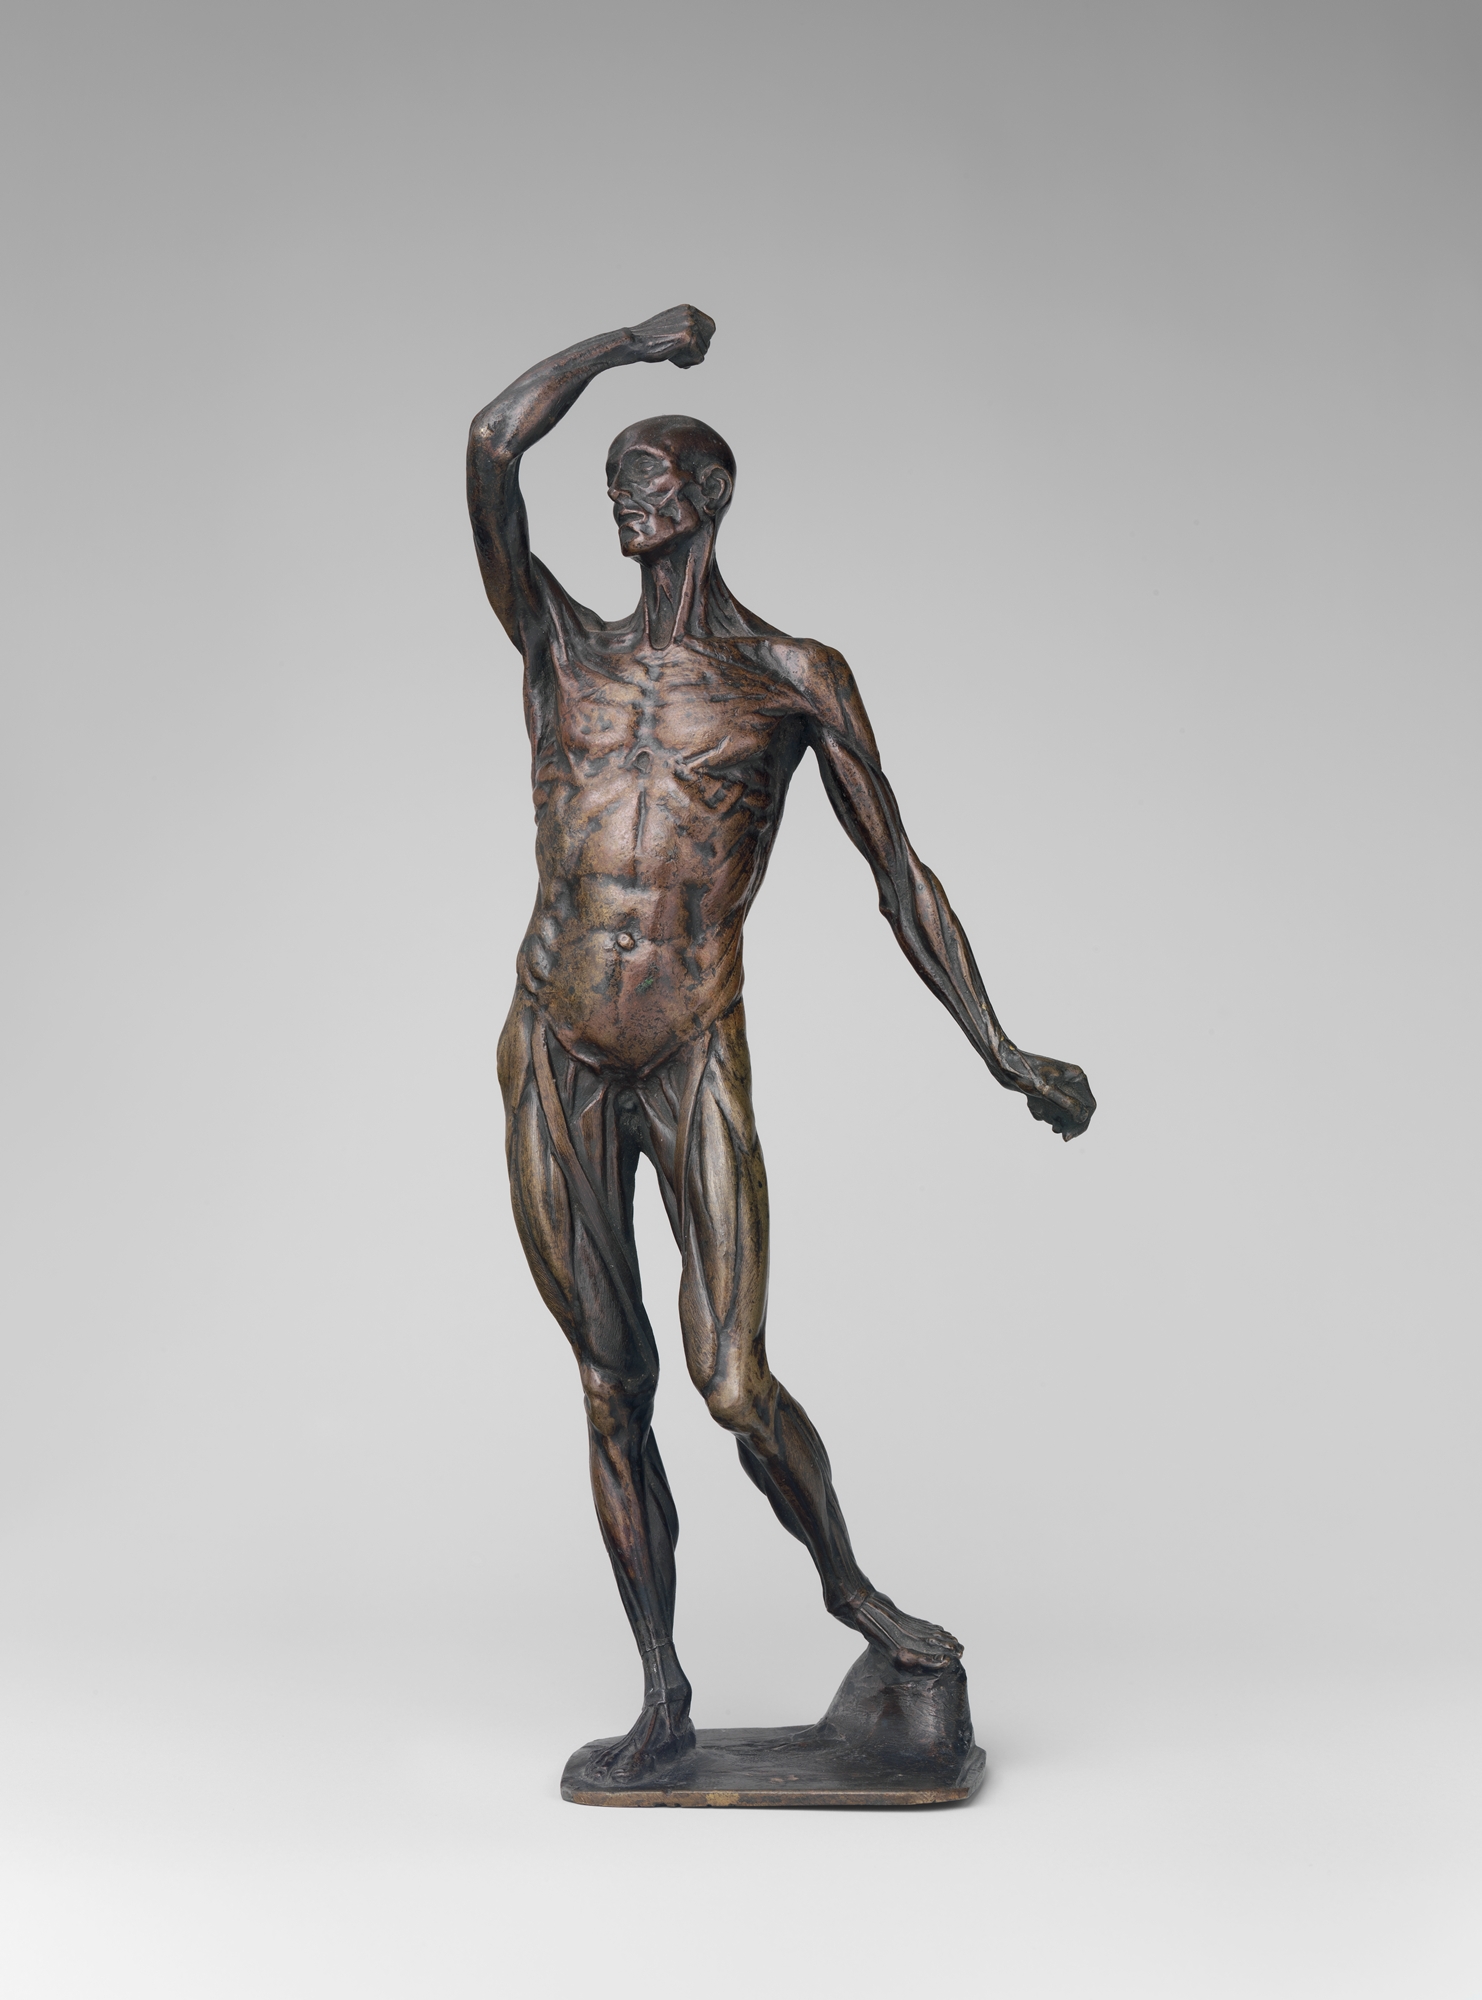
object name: statuette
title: Ecorché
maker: michael henry spang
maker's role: maker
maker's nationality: danish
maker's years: 1662-1762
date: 1761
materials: bronze, marble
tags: male nudes